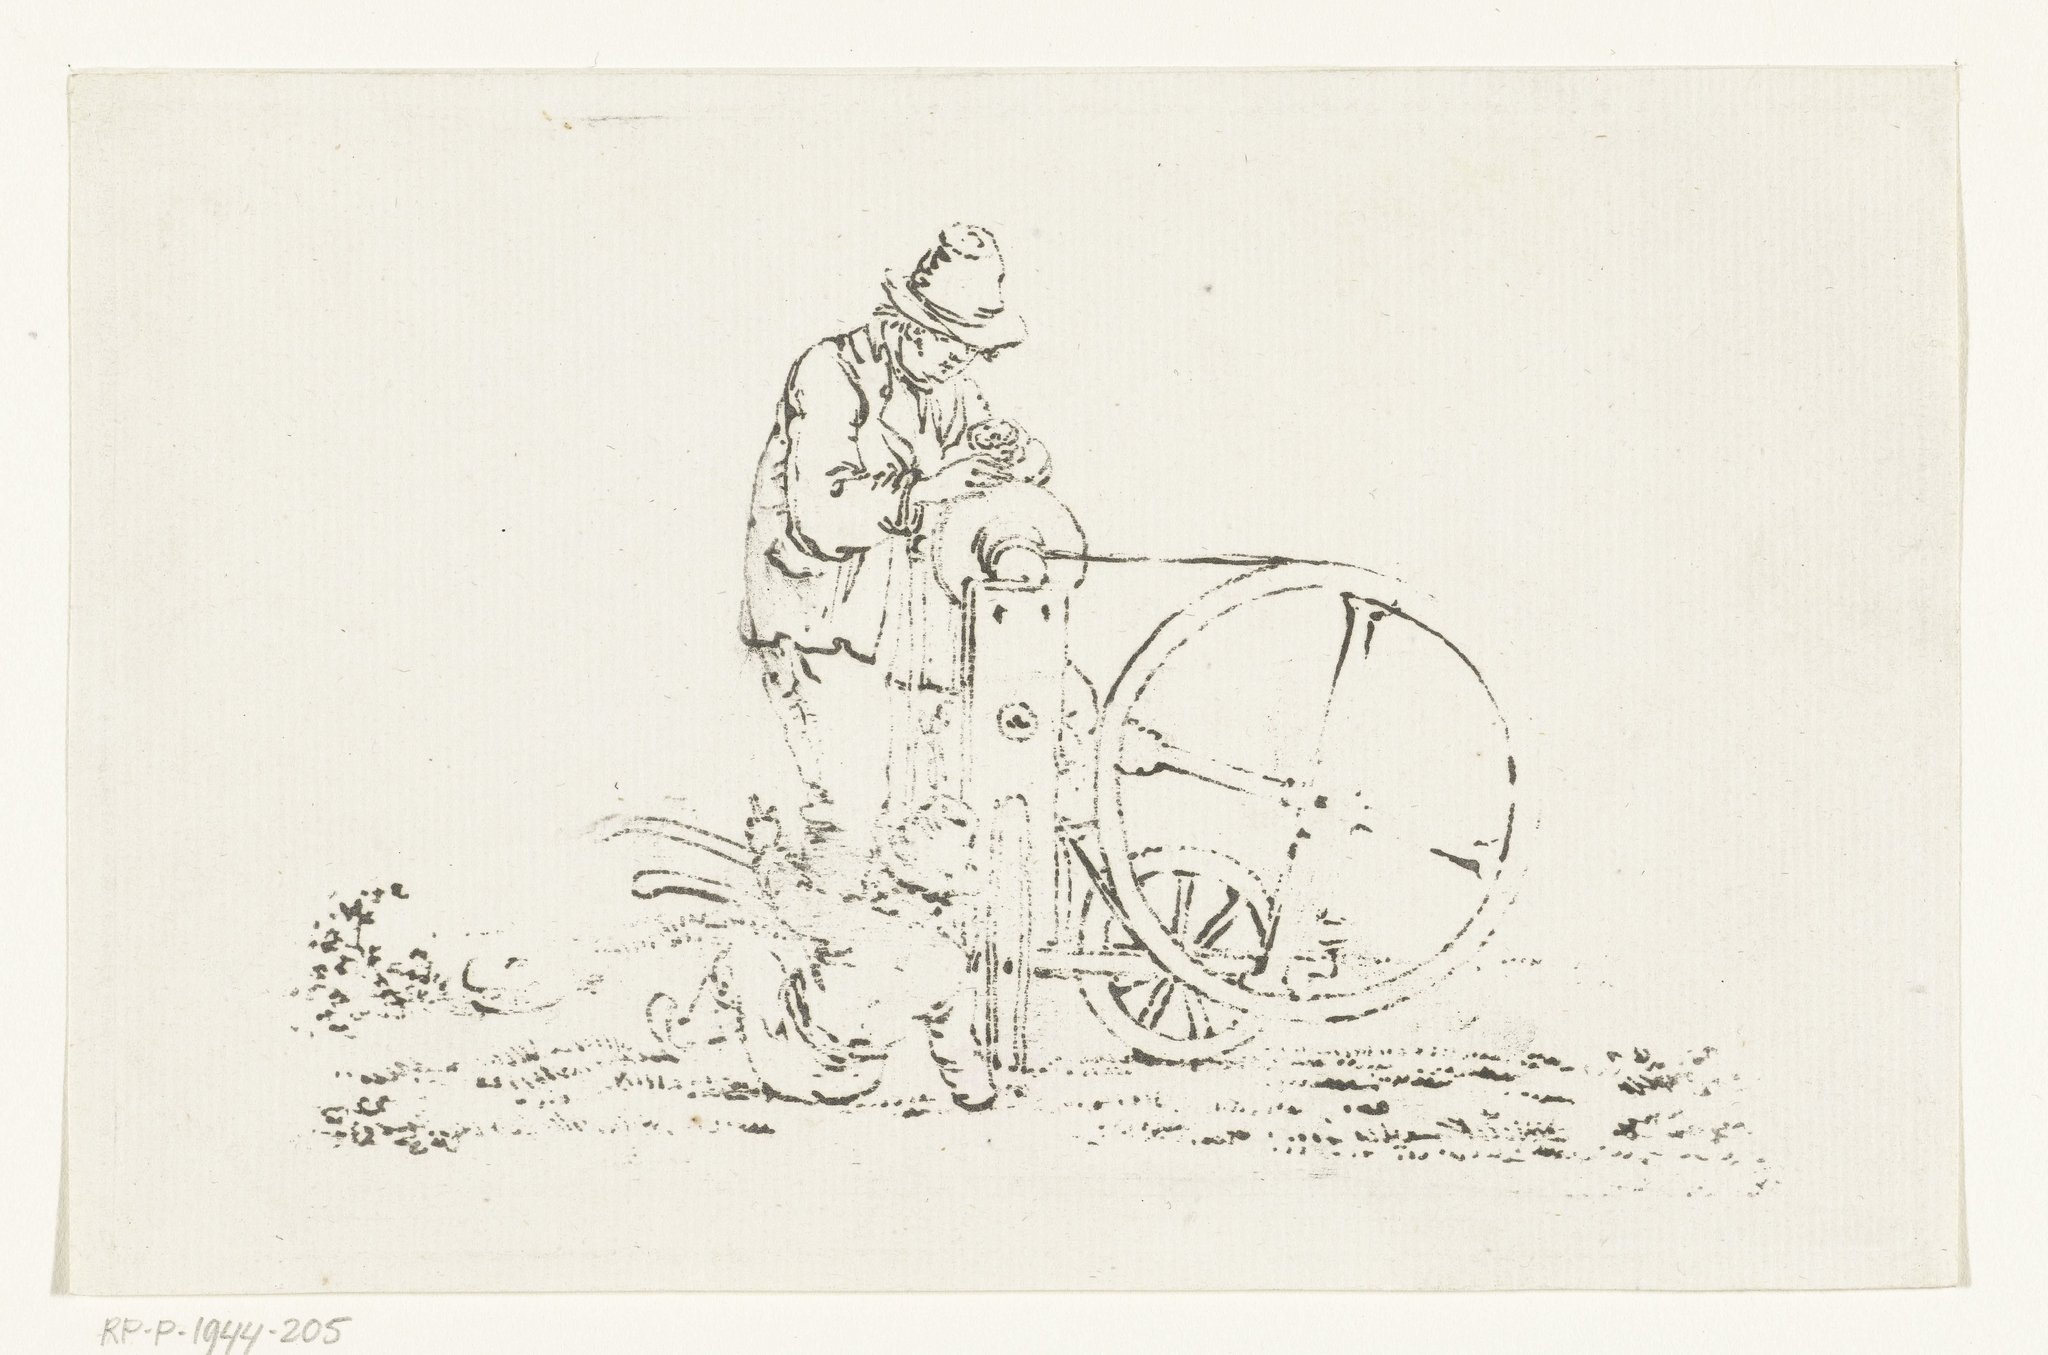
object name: print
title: Scharenslijper aan het werk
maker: pieter barbiers (iv)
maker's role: painter, print maker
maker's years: 1798-1848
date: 1808-1848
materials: paper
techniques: soft ground etching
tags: sharpening, grinding (industrial processes), tools, aids, implements ~ crafts and industries: grindstone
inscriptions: collector's mark: Lugt 2228